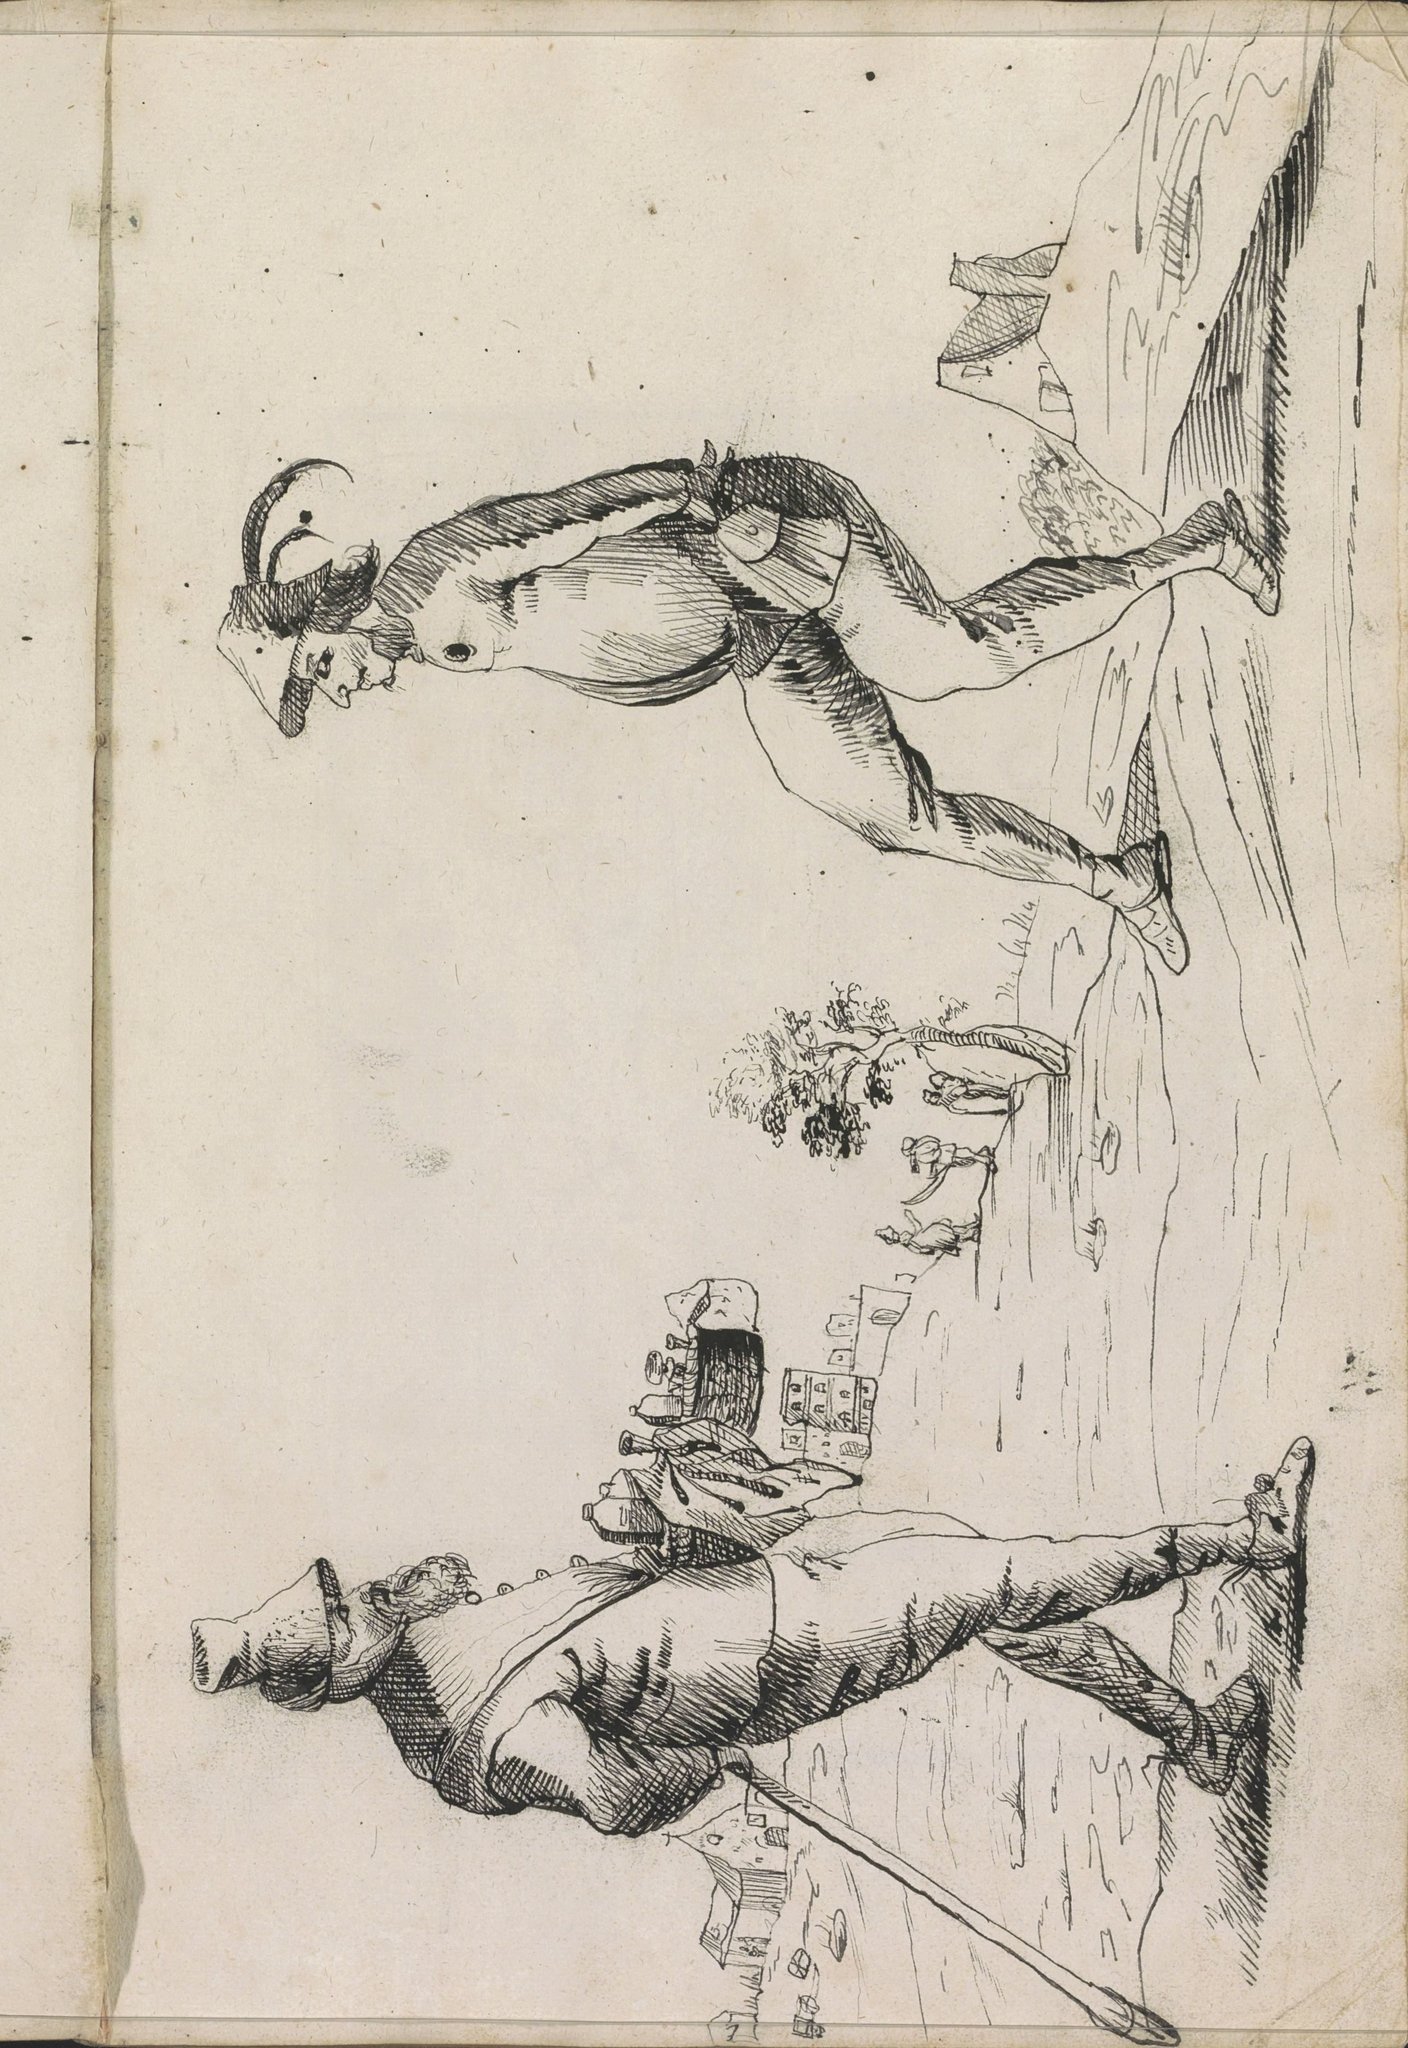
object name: sketchbook leaf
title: Marskramer leunend op een stok en een dansende man in een landschap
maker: hendrick van beaumont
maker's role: draughtsman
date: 1696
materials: ink, paper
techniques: pen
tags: man dancing alone, merchant, salesman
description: Blad 26 recto uit een schetsboek met 91 bladen.